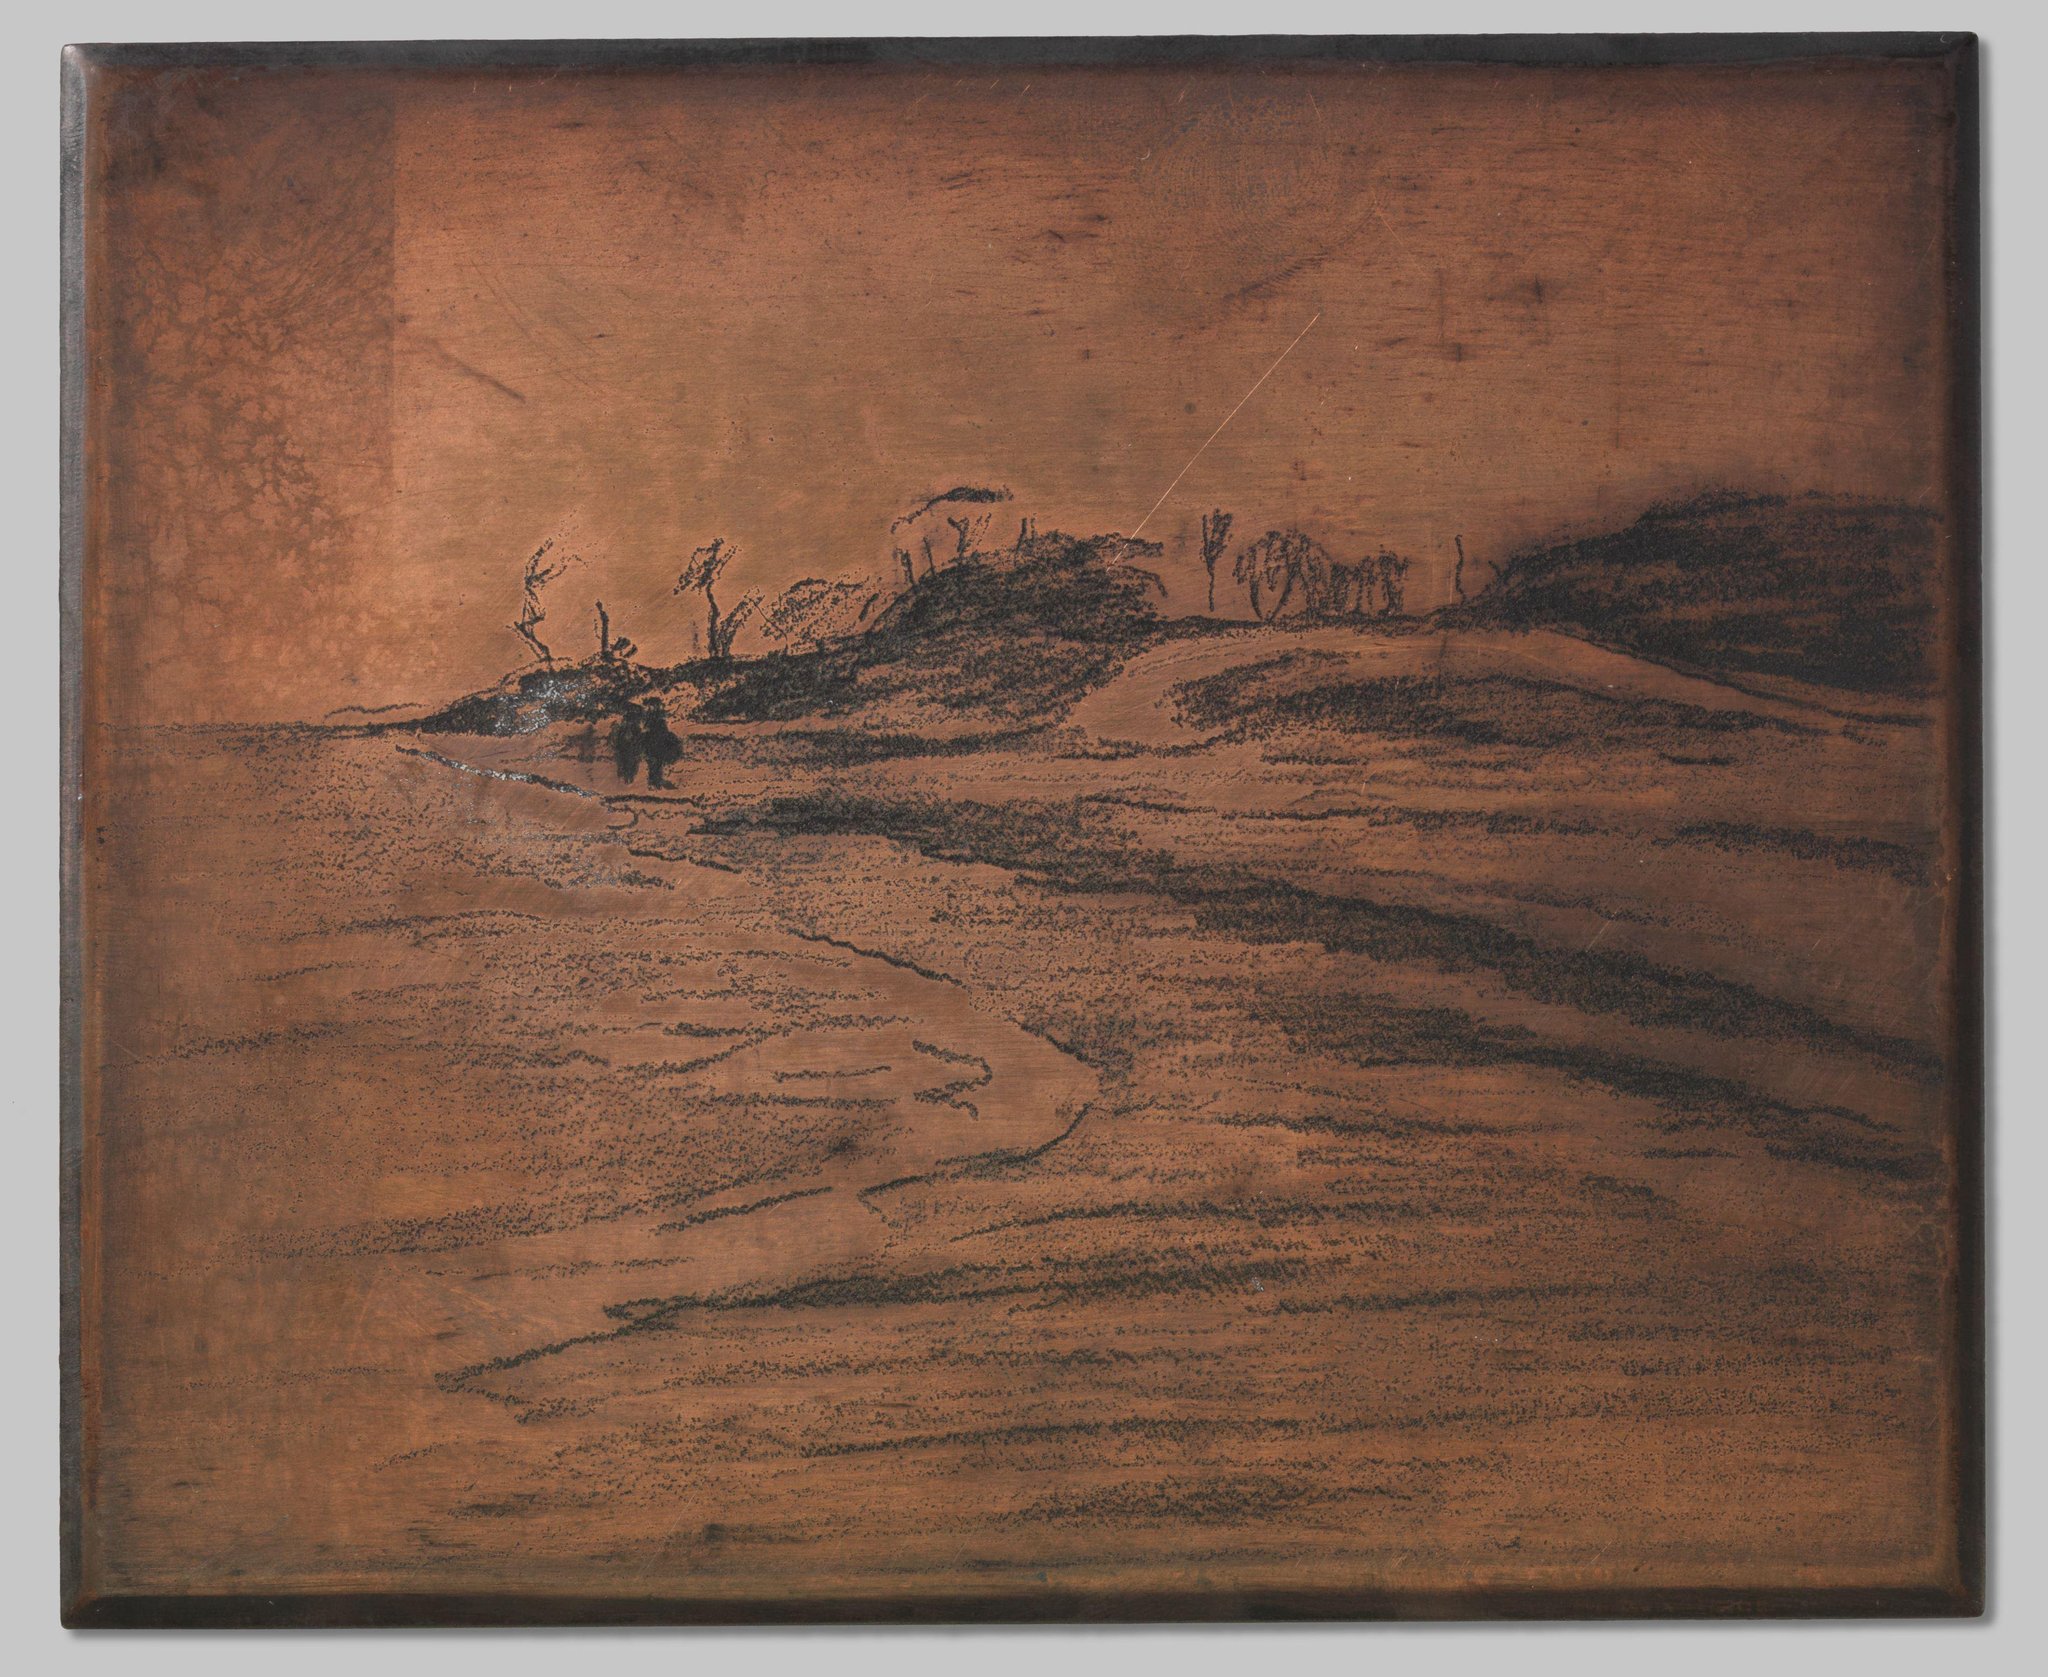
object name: copper plate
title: Valkeveen aan de Zuiderzee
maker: willem witsen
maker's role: draughtsman, painter, print maker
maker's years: 1860-1923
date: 1913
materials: copper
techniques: soft ground etching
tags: valkeveen